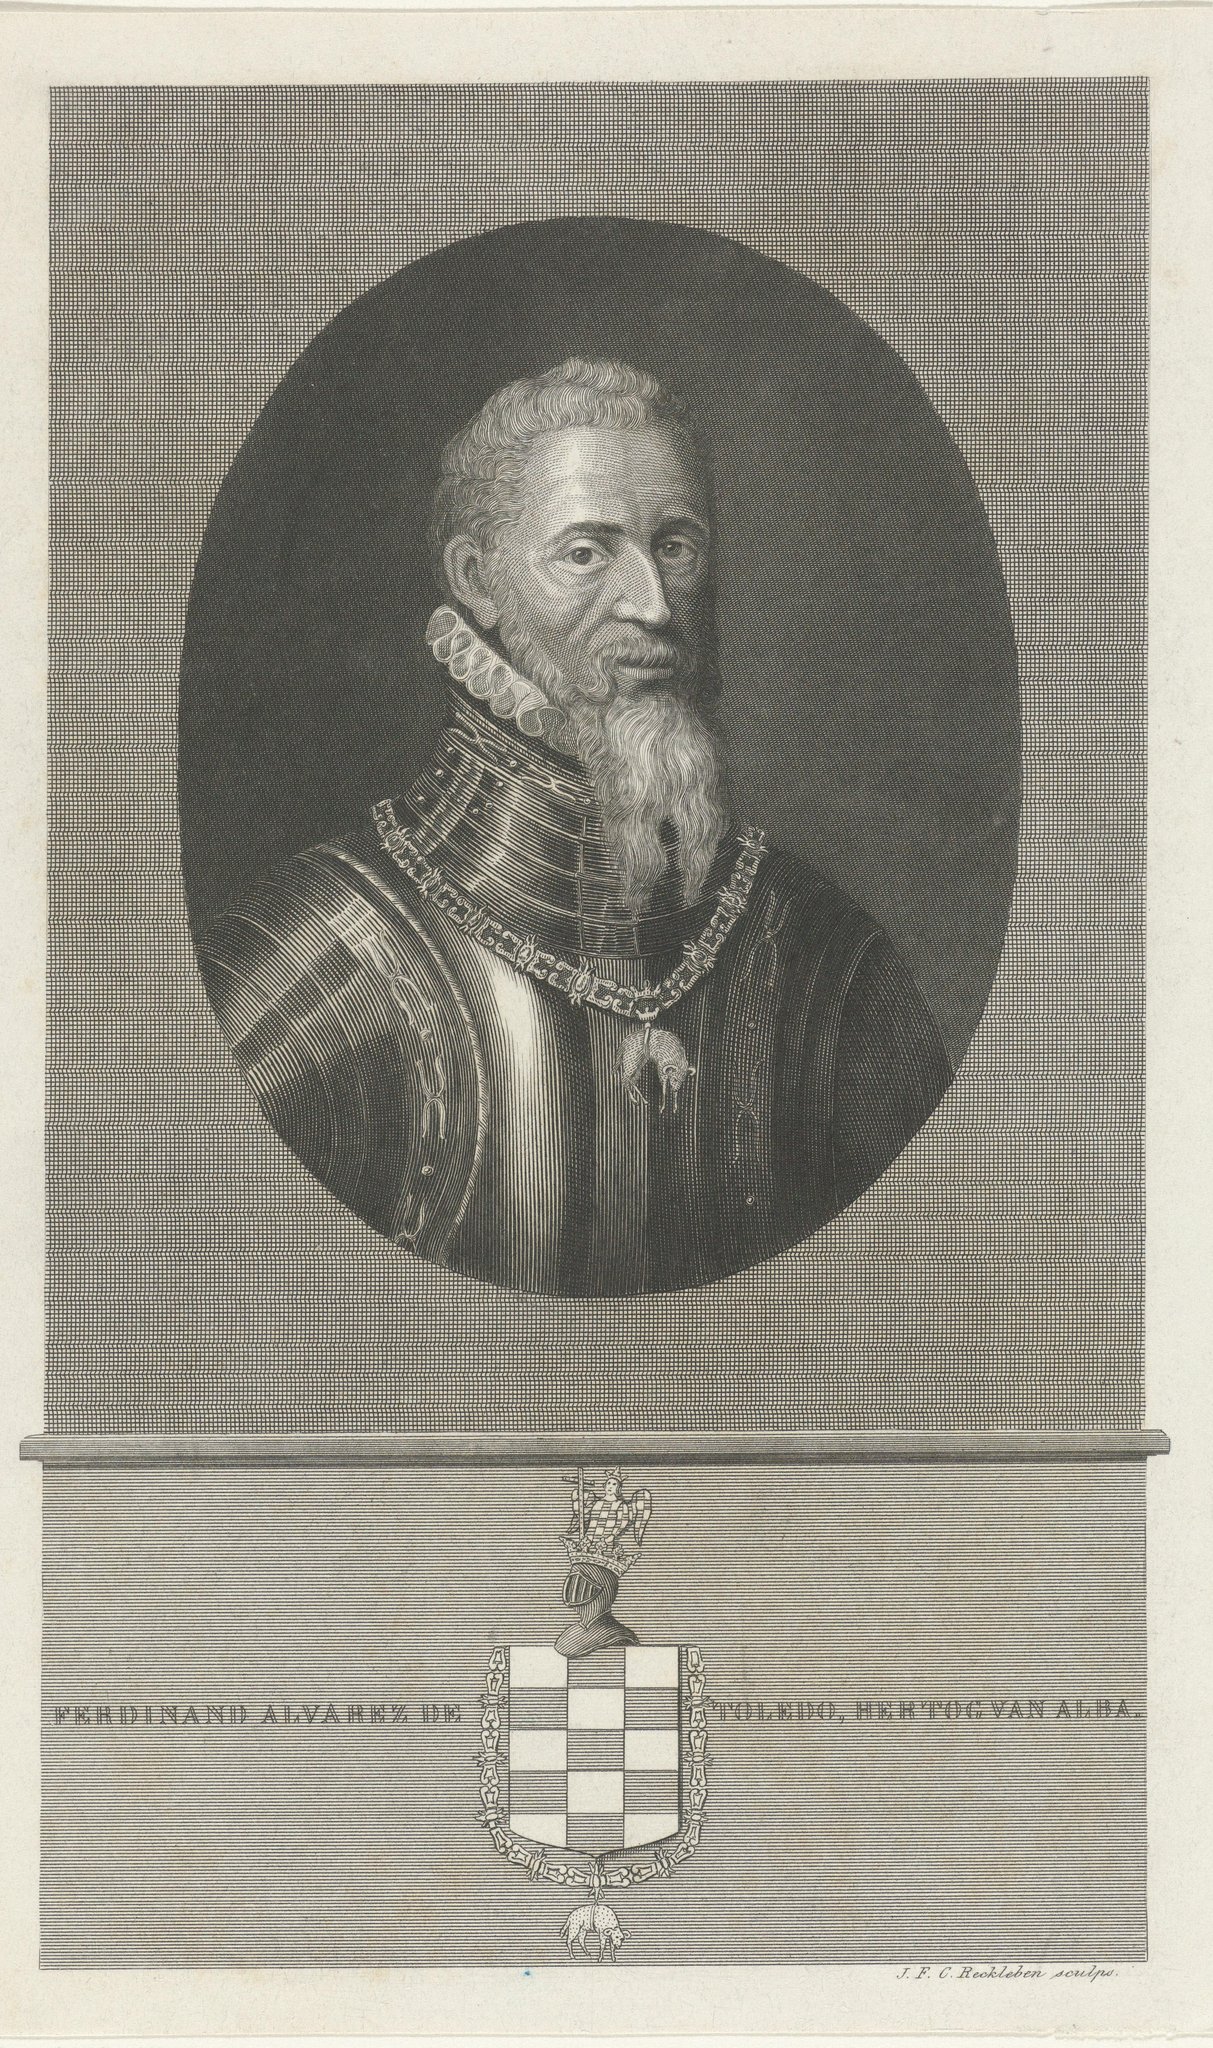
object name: print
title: Portret van Ferdinand Alvarez de Toledo, hertog van Alva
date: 1849-1851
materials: paper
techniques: engraving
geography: amsterdam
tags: fernando álvarez de toledo (3rd duke of alba), knighthood order of the golden fleece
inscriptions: collector's mark: Lugt 2228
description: Portret van Ferdinand Alvarez de Toledo, hertog van Alva (ook wel de IJzeren Hertog genoemd). Om de hals een ketting met het embleem van de Orde van het Gulden Vlies. In de marge zijn naam, titel en familiewapen.